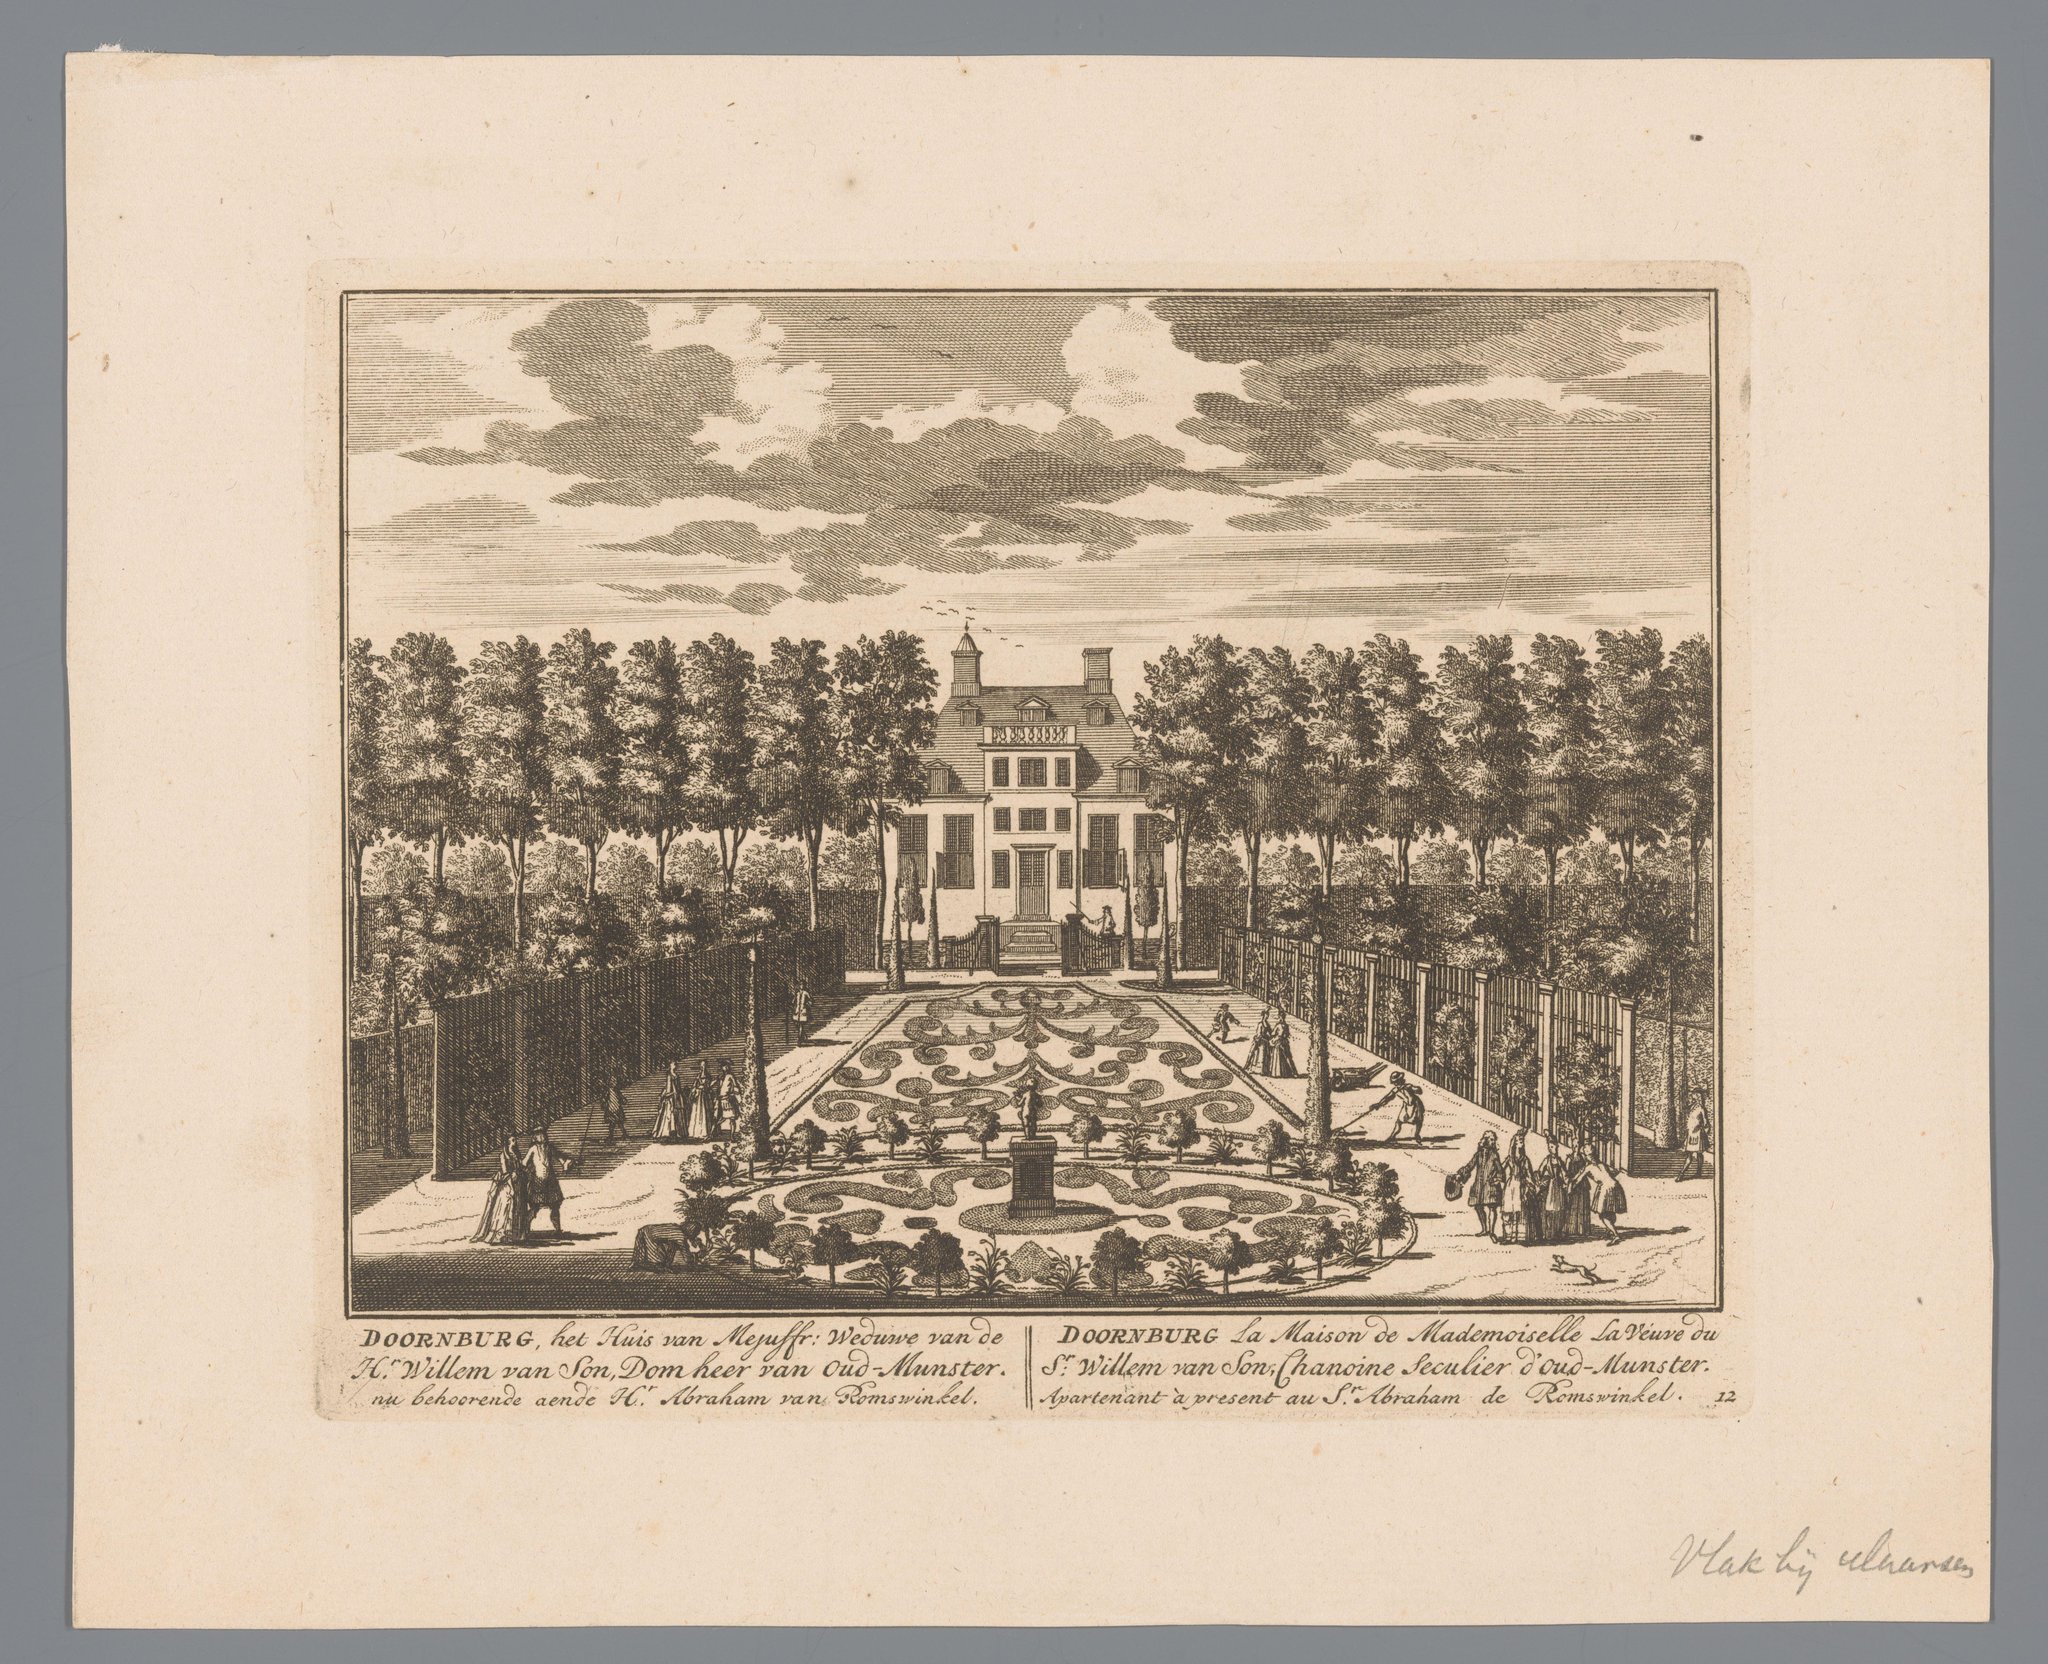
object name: print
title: Doornburg, het Huis van Mejuffr: Weduwe van de H. Willem van Son, Dom heer van Oud-Munster (...) / Doornburg la Maison de Mademoiselle La veuve du Sr. Willem van Son (...)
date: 1719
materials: paper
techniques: etching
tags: rural housing, e.g. country-house, villa, cottage, french or architectonic garden; formal garden, maarssen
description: Prent uit: De zegepraalende Vecht, vertoonende verscheidene gesichten van lustplaatsen, heeren huysen en dorpen, beginnende van Uitrecht en met Muyden besluytende. Amsterdam: Wed. Nicolaes Visscher, 1719.